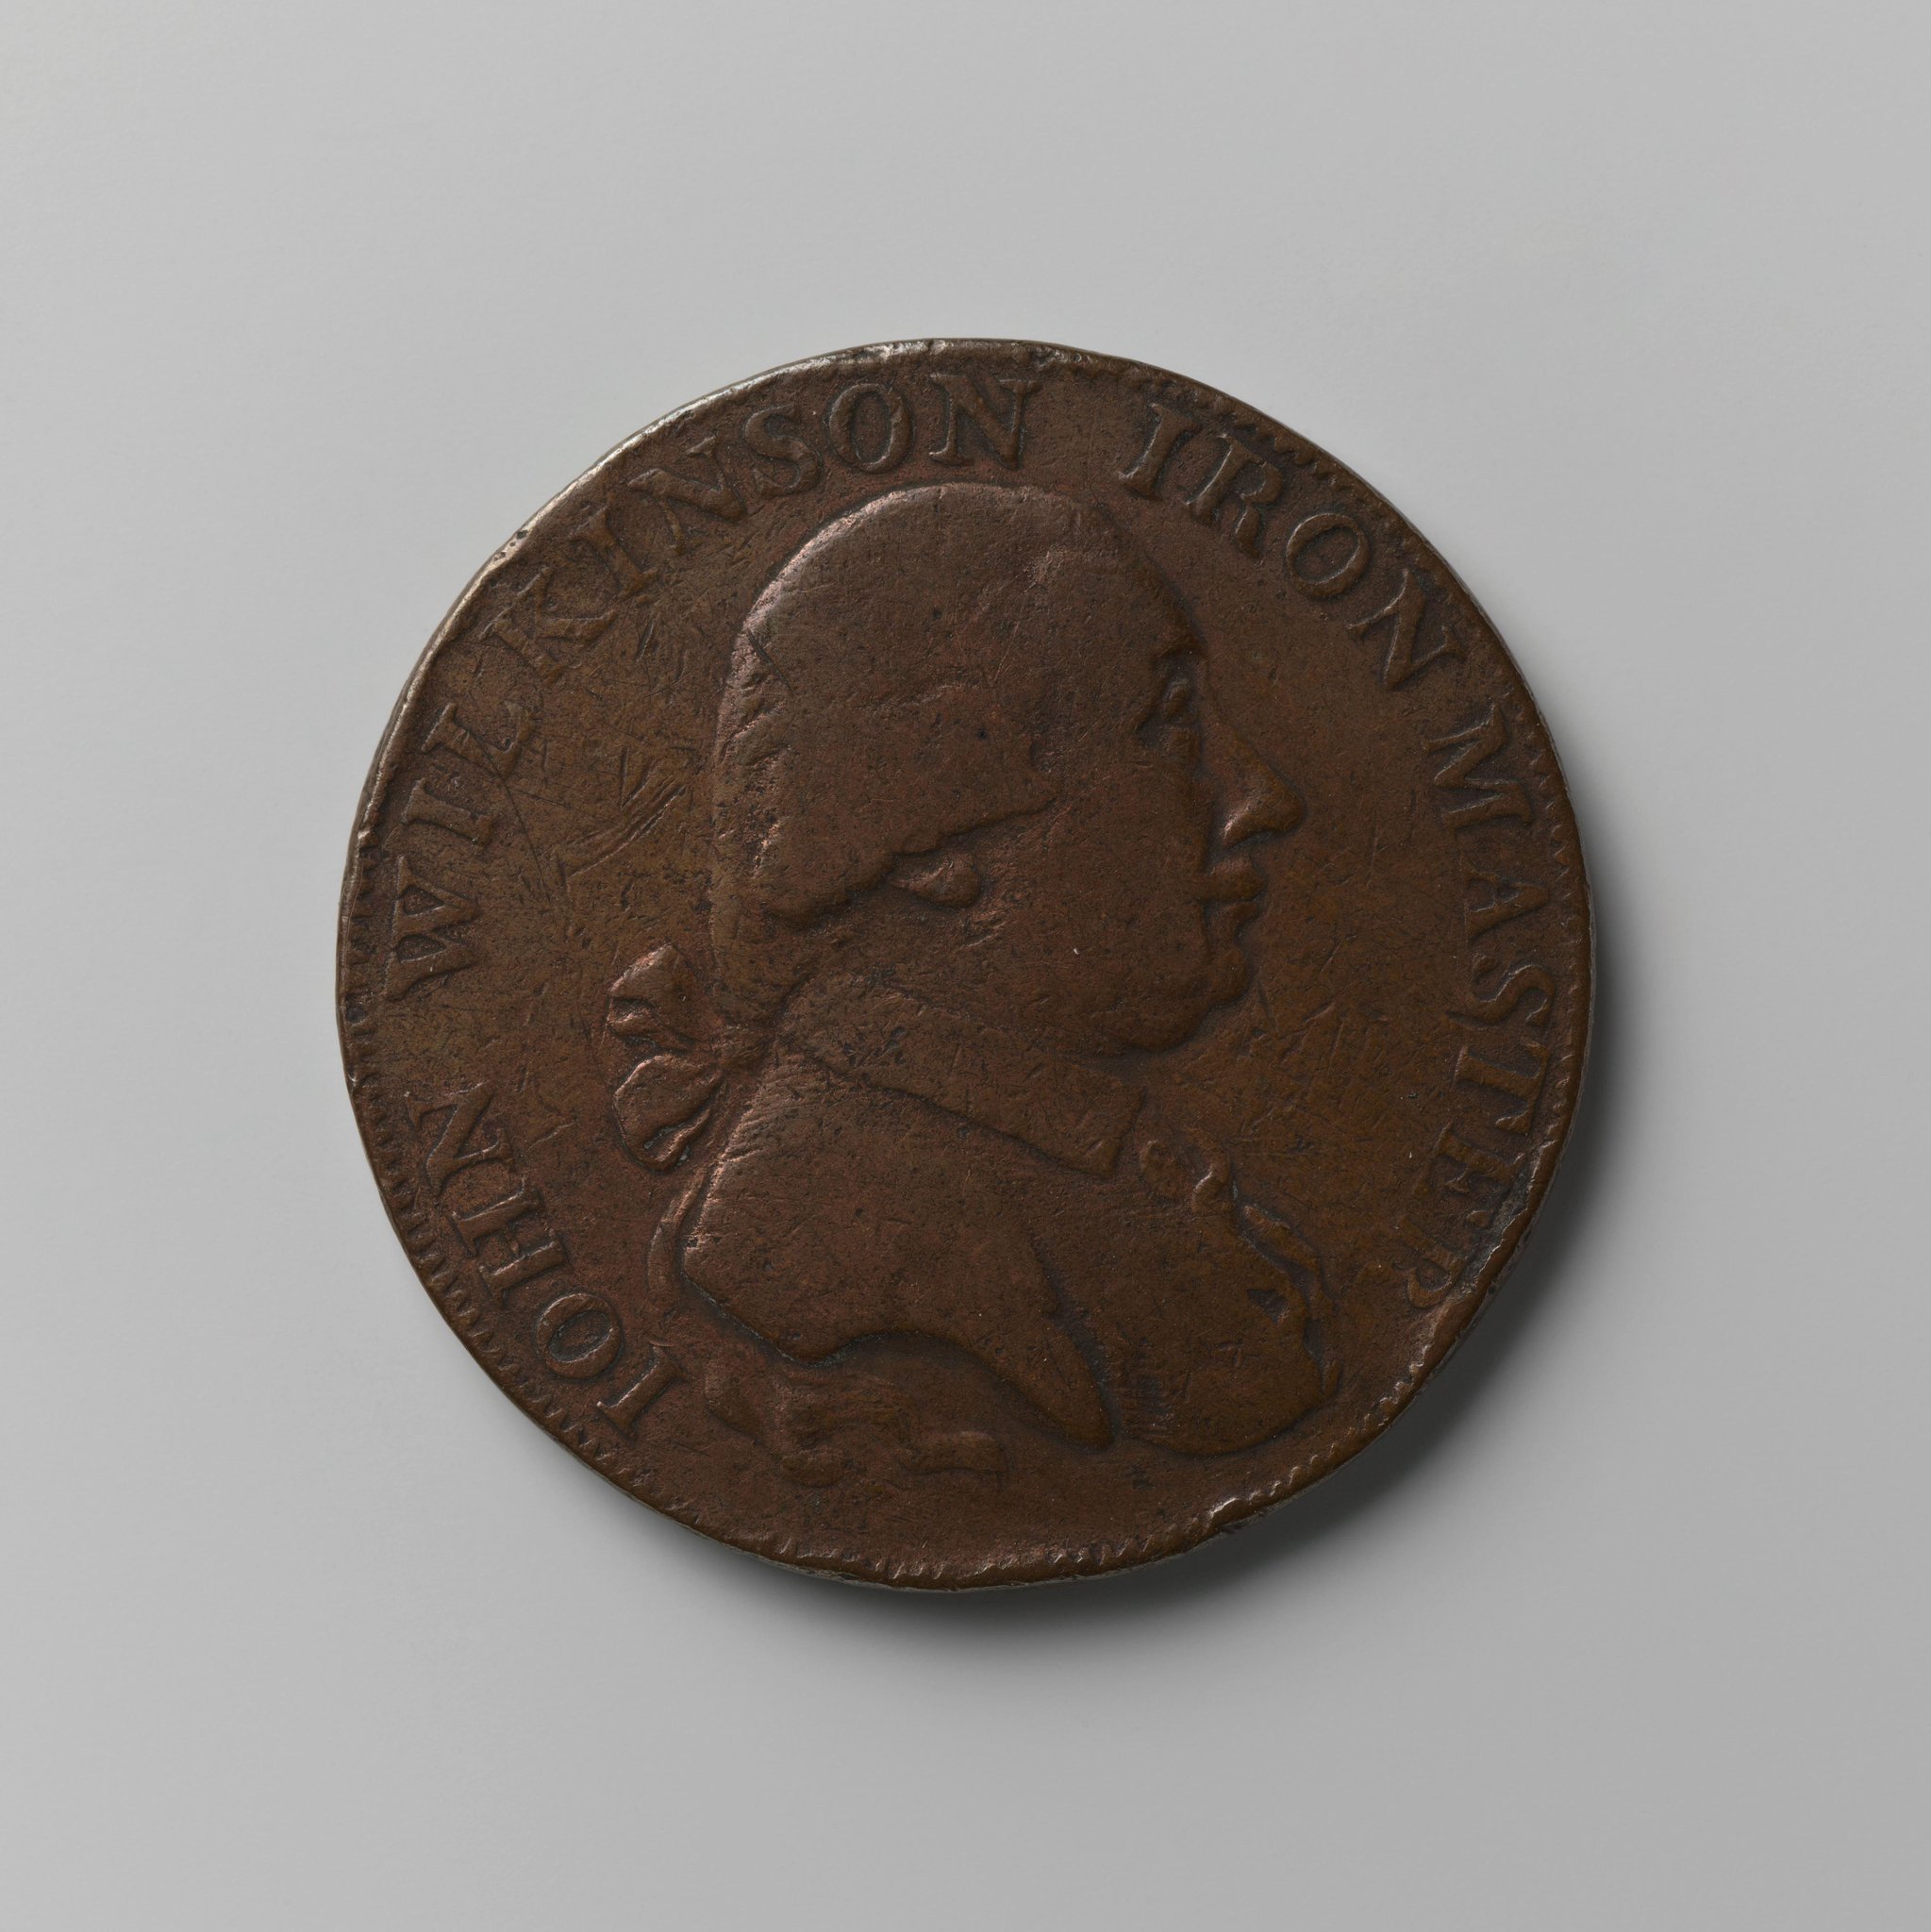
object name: penny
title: Penny-token, Willey, Engeland, 1790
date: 1790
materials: copper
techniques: striking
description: Koperen particuliere munt. Voorzijde: man, werkzaam in een gieterij. Keerzijde: borstbeeld van een man naar rechts. Randschrift.